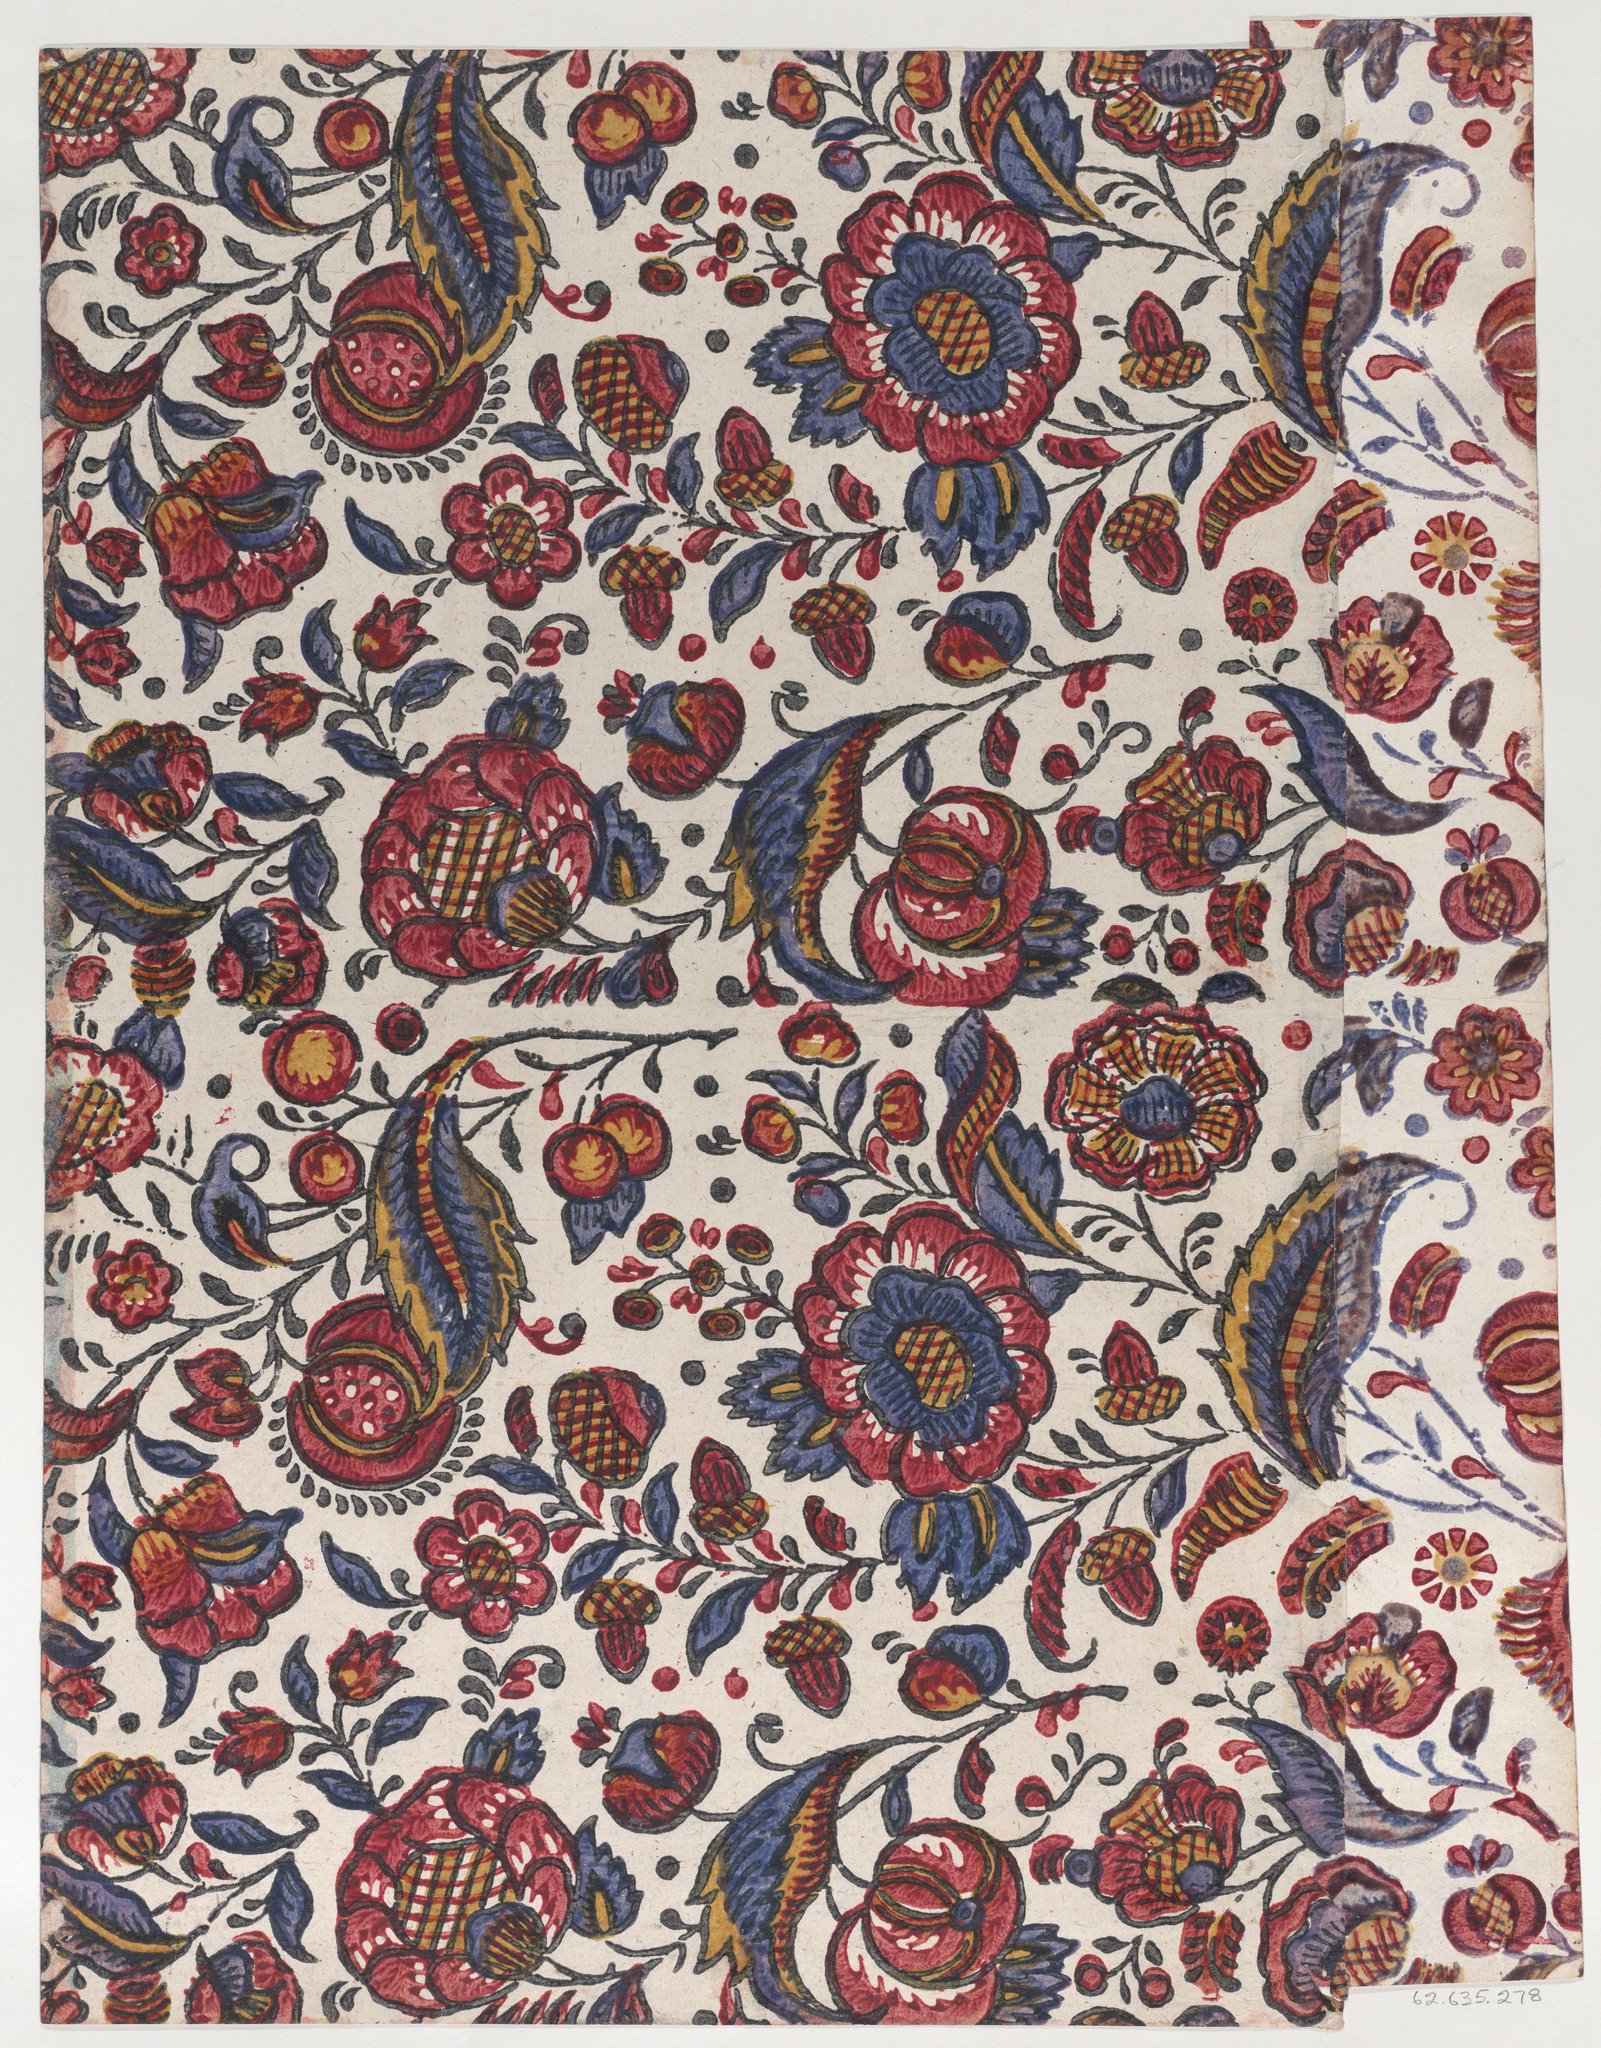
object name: print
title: Paste paper with overall pattern of red, blue, and yellow flowers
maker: Anonymous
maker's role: artist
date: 1801-1900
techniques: relief print